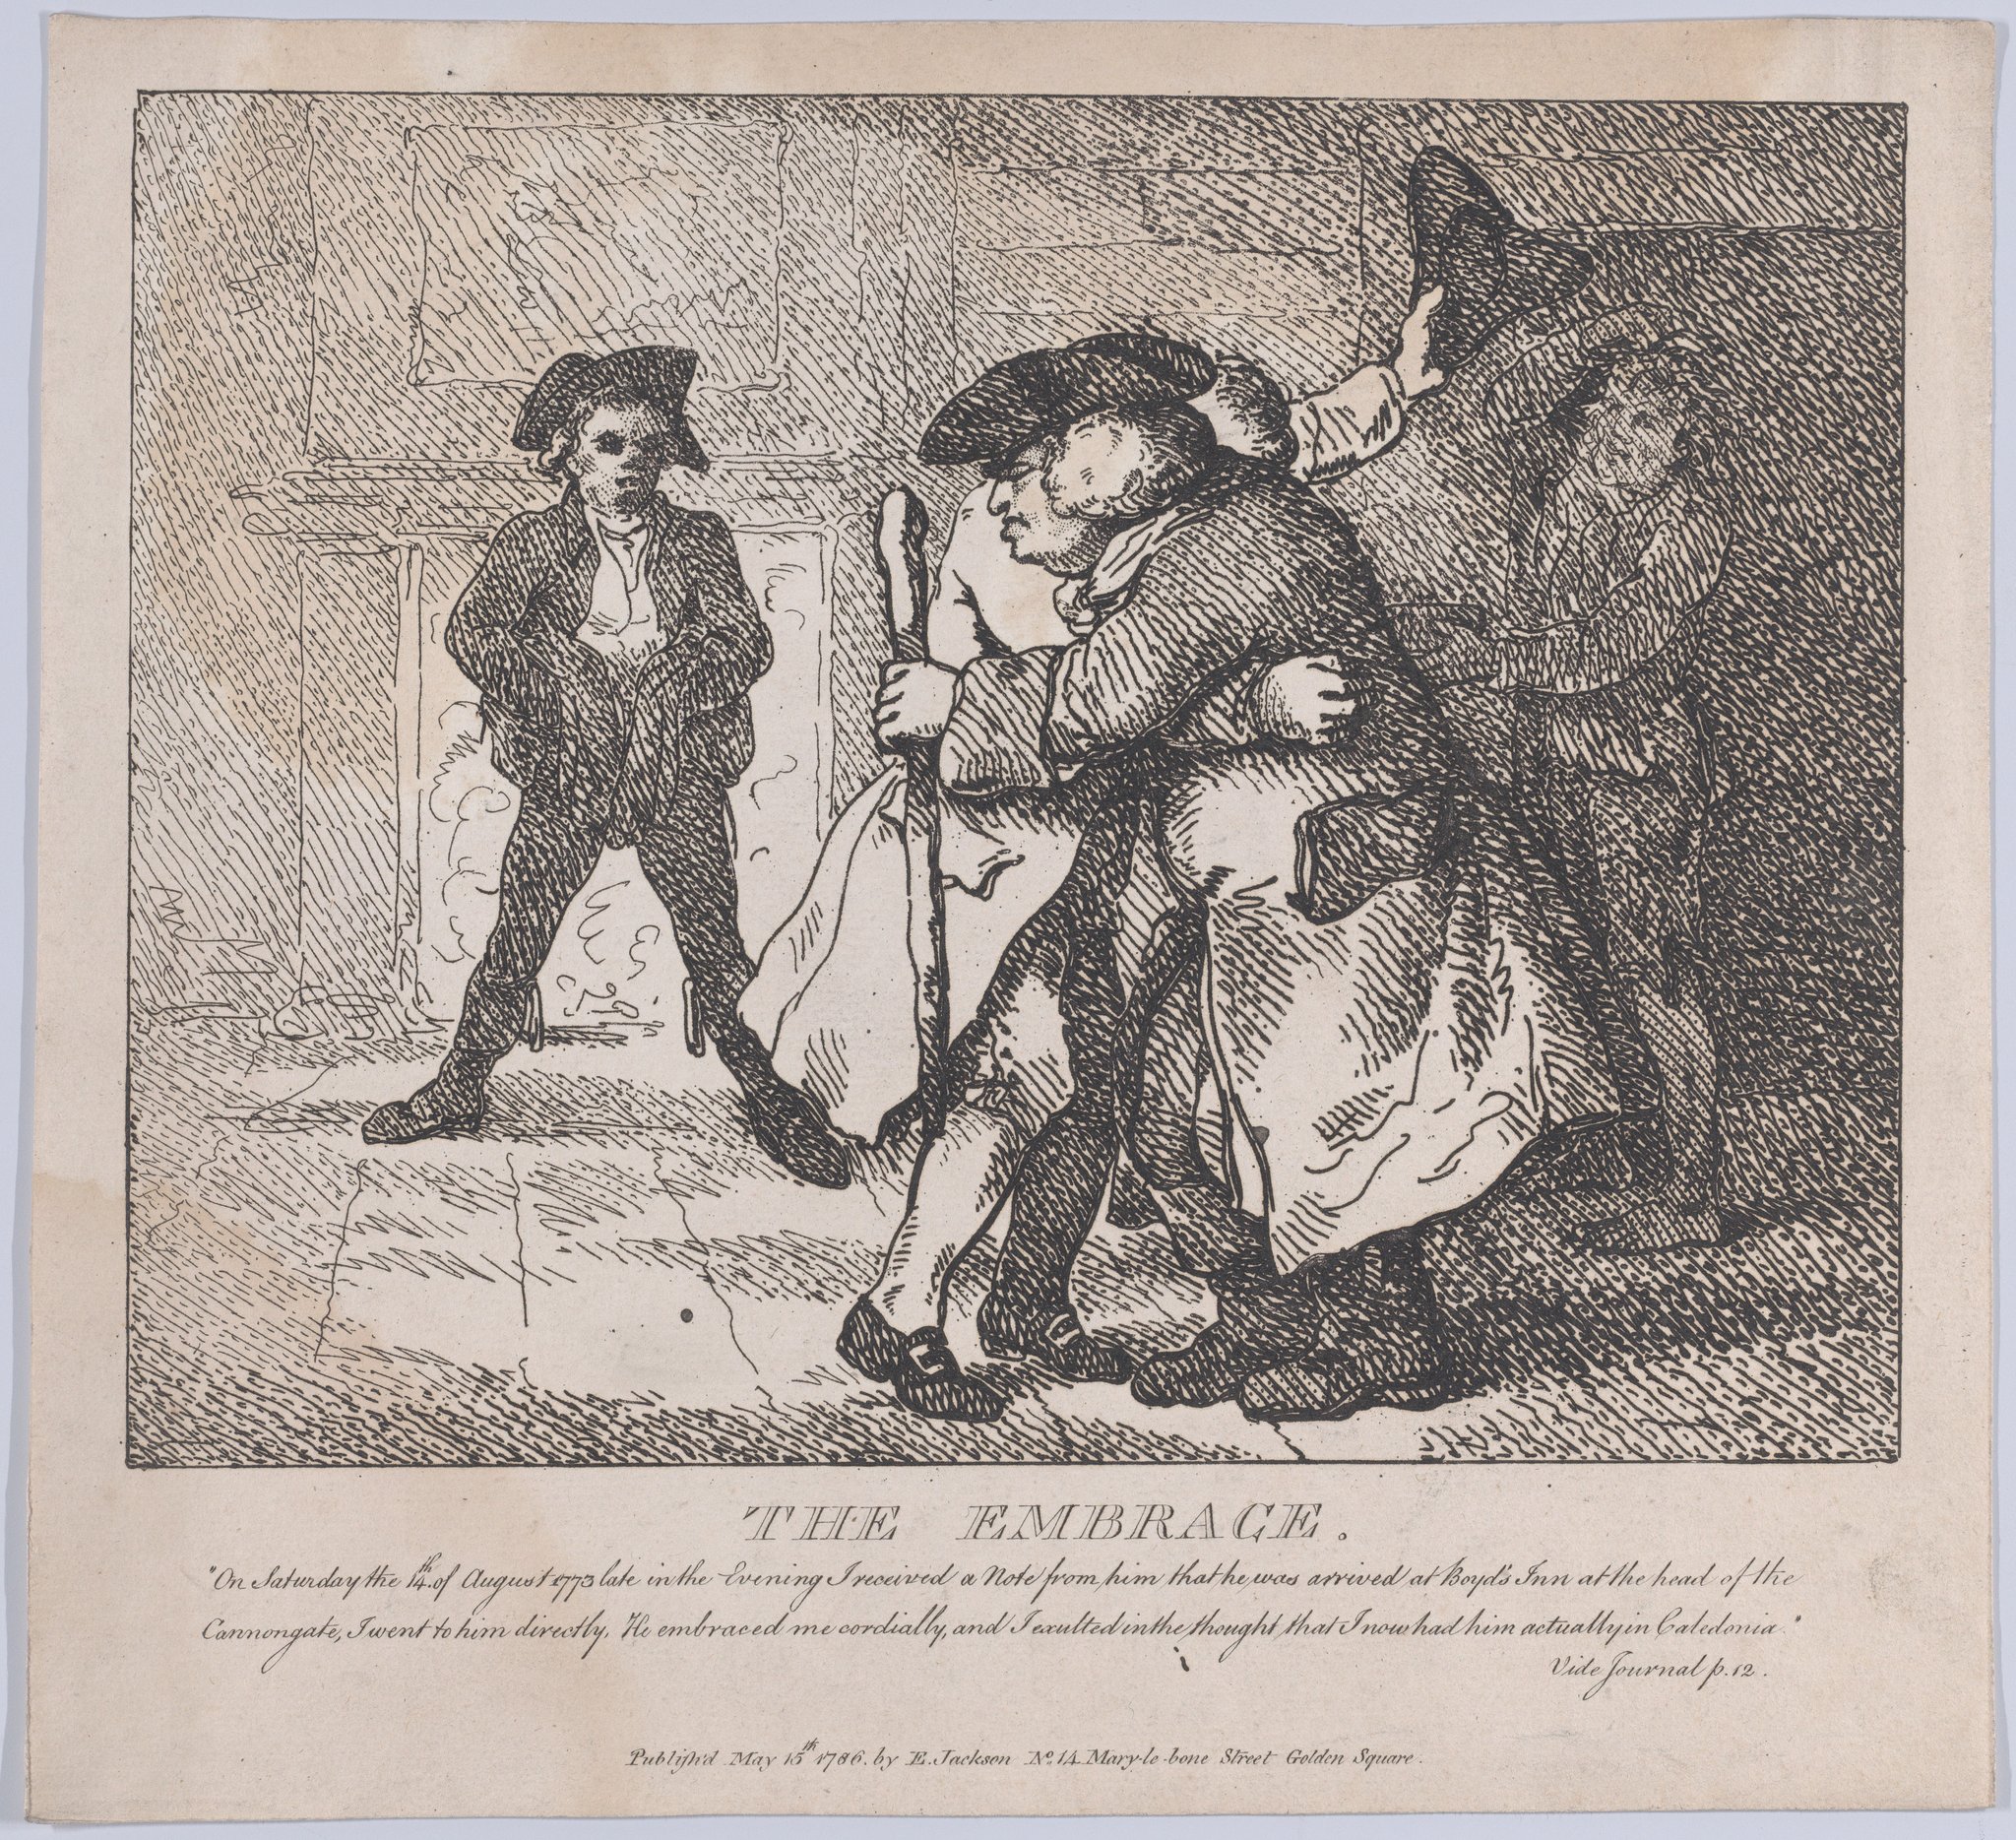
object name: print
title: The Embrace (Picturesque Beauties of Boswell, Part the First)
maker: thomas rowlandson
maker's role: artist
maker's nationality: british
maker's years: 1757-1827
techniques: etching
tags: satire,men